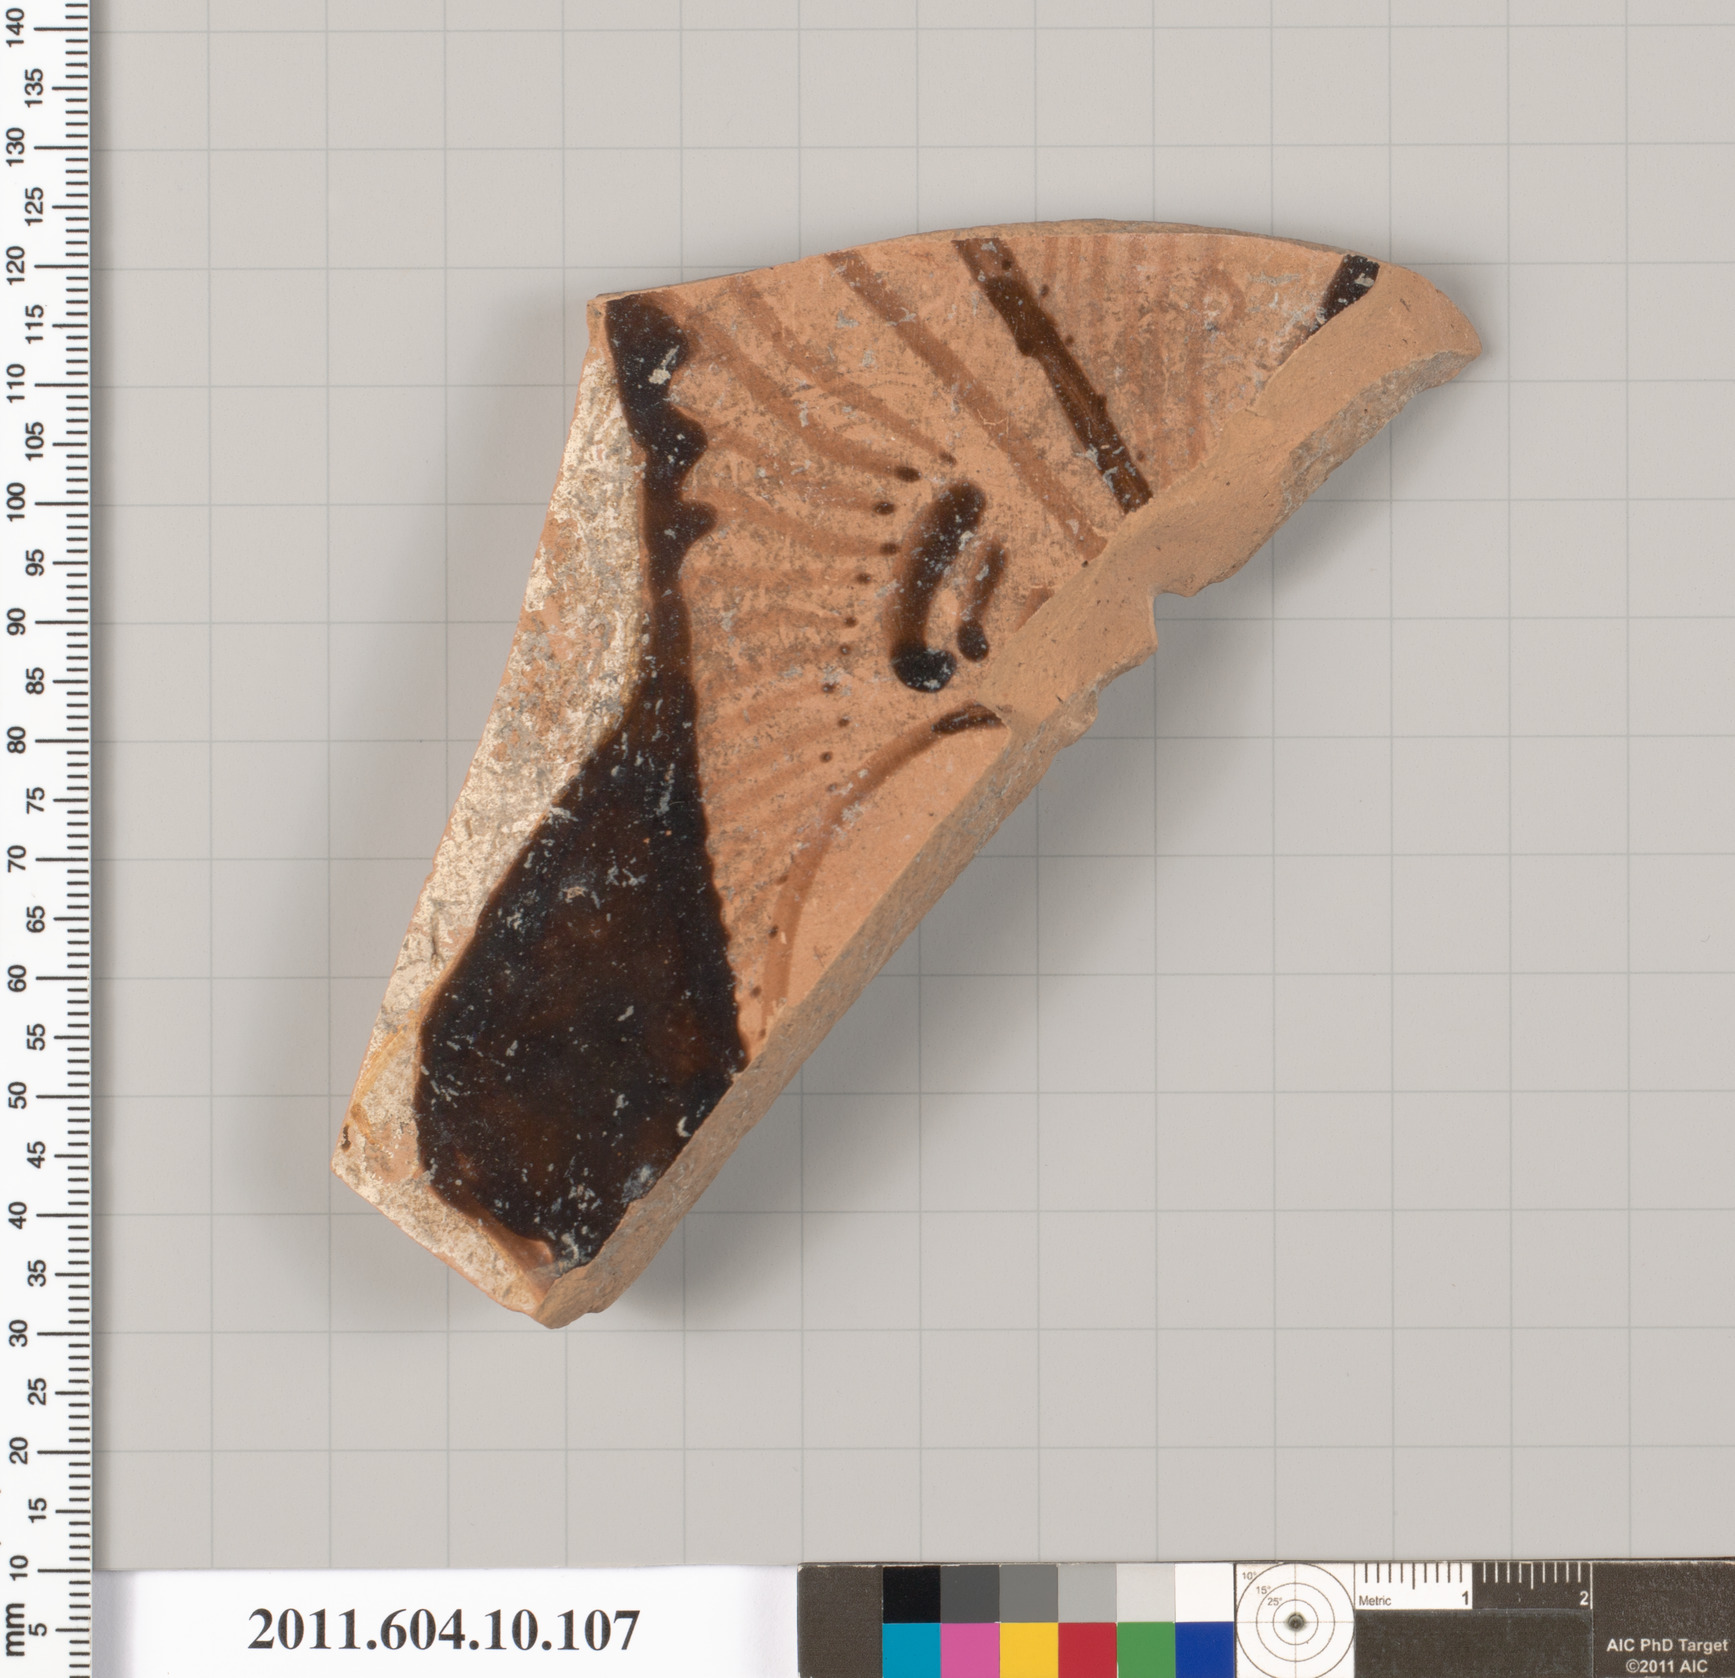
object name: krater fragment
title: Terracotta fragment of a krater (deep bowl)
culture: etruscan or faliscan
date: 400-301 BCE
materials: terracotta